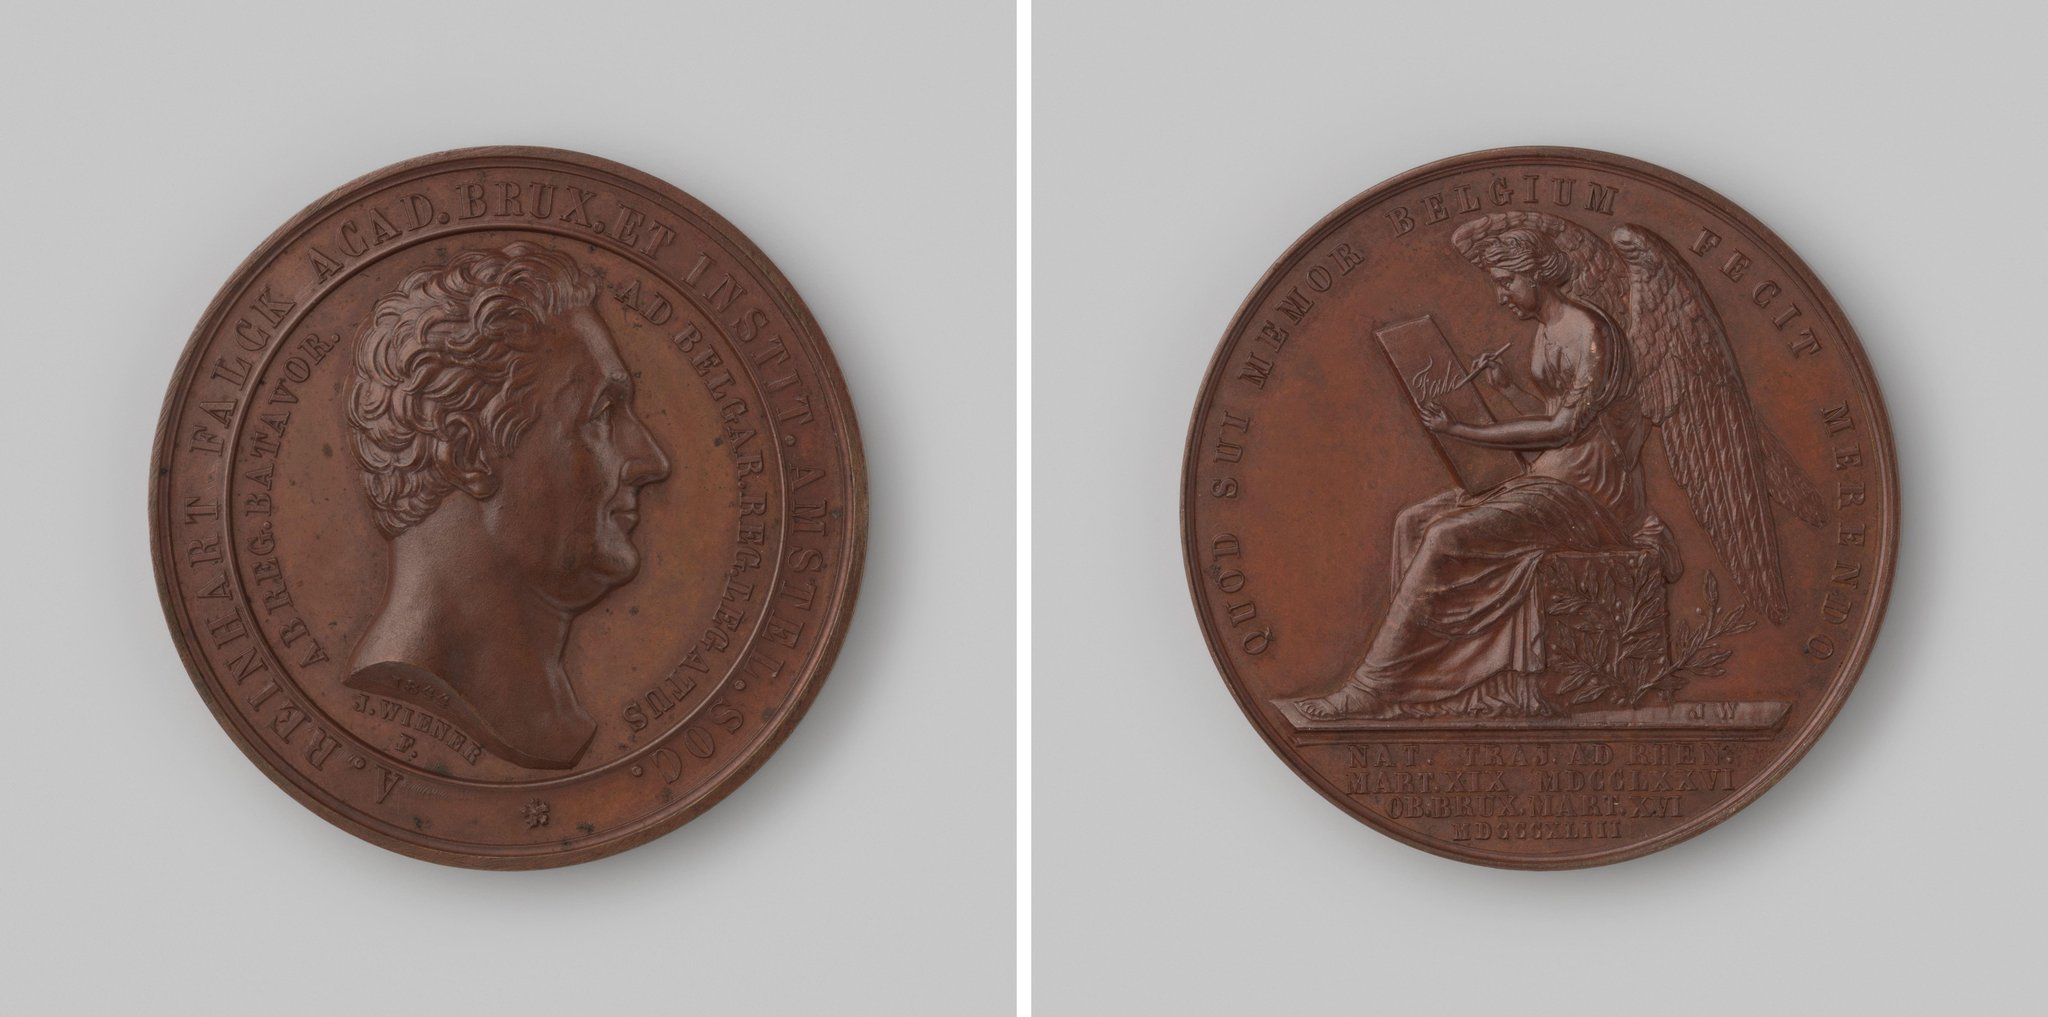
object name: history medal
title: Op het overlijden van Anton Reinhart Falck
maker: jacob wiener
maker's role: medailleur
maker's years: 1815-1899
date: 1843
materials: bronze